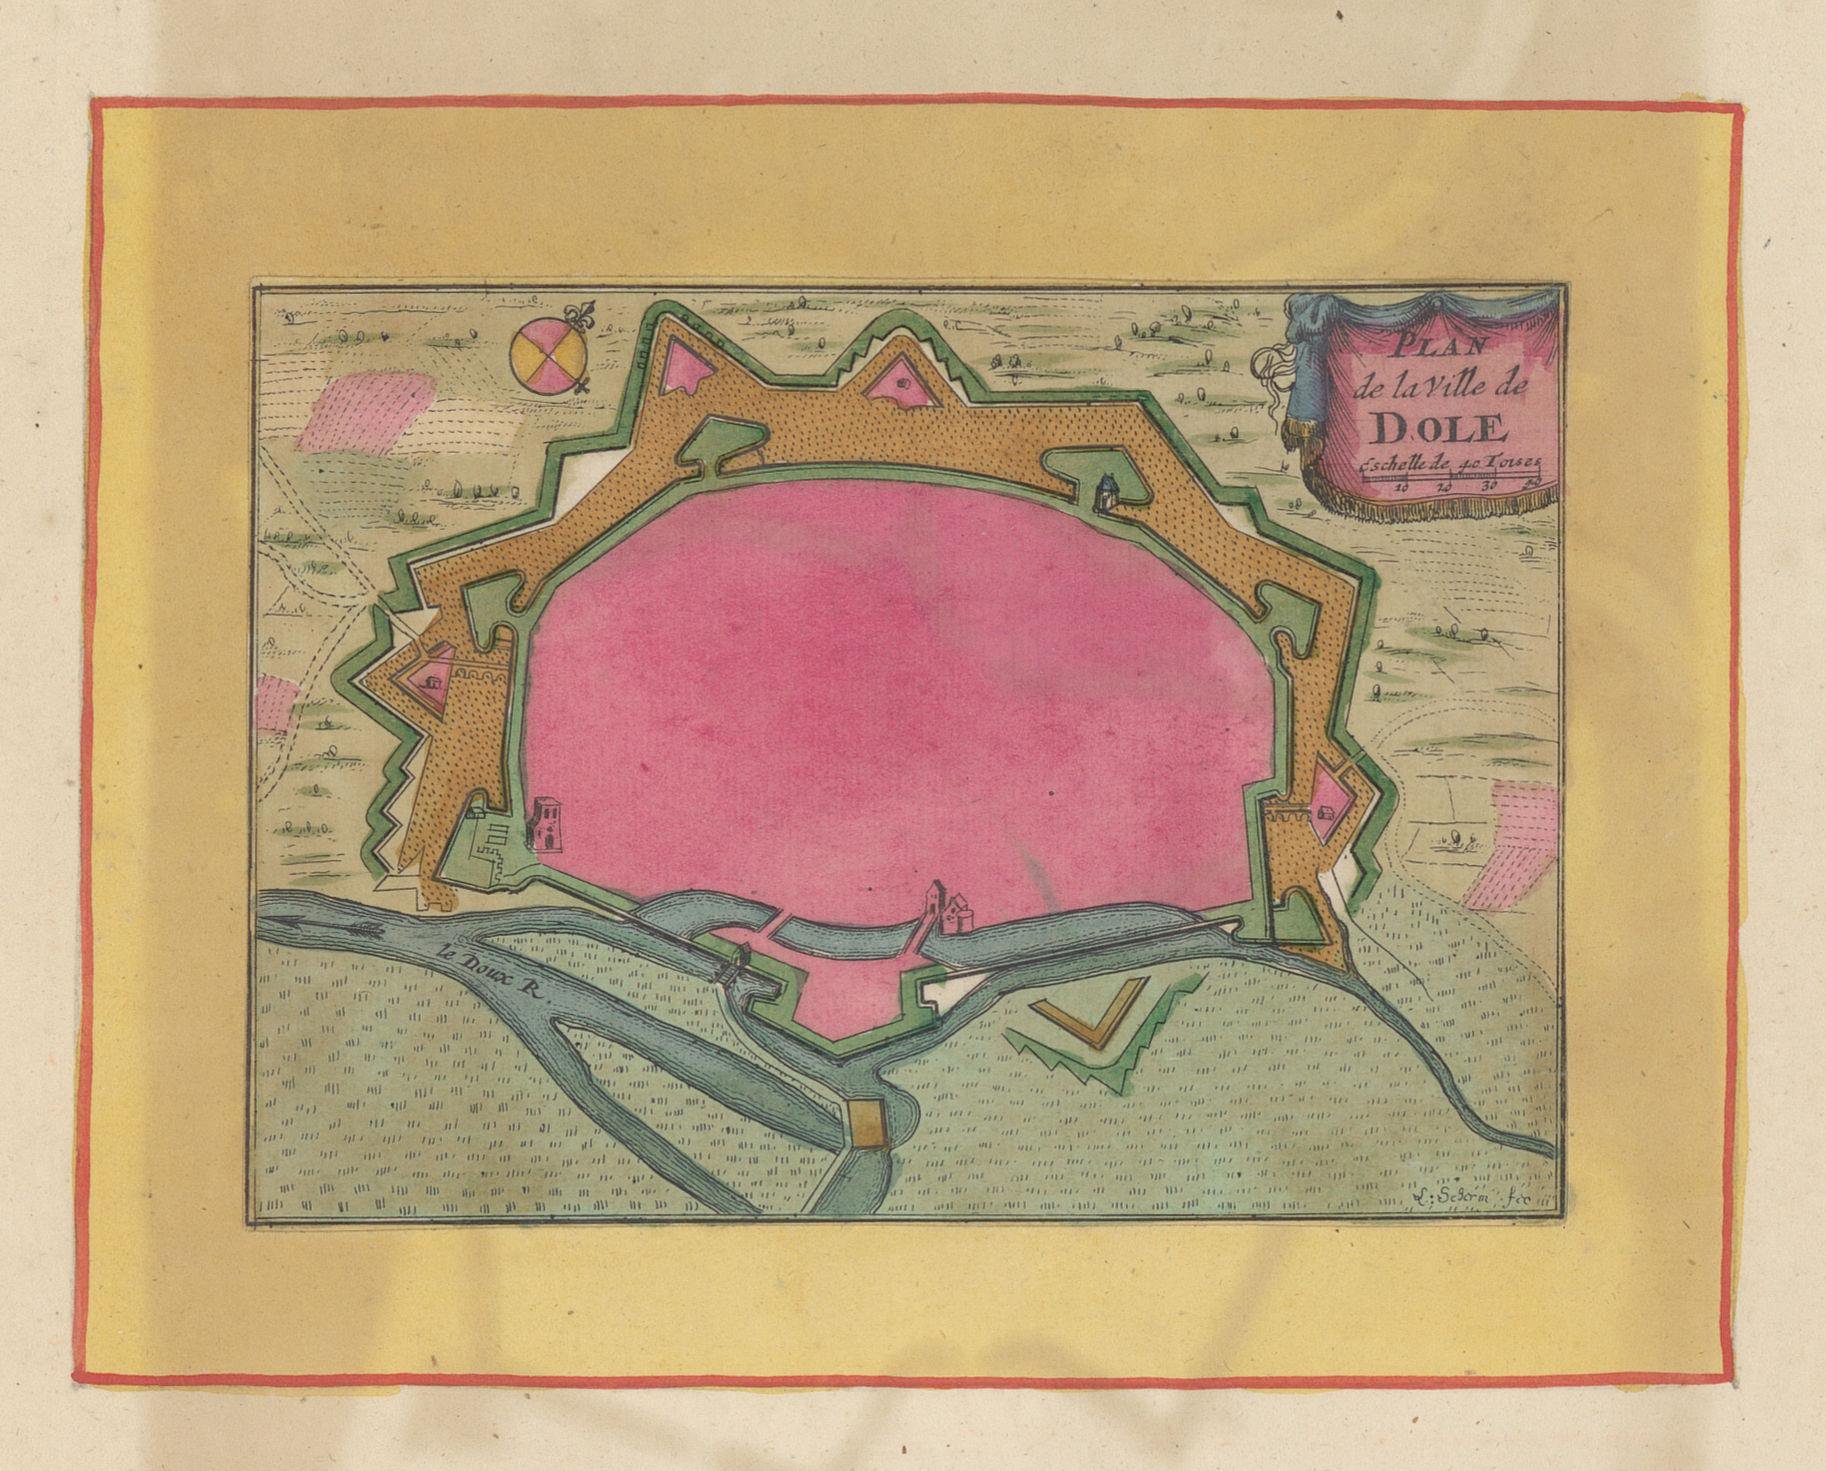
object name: area plan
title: Vestingplattegrond van Dôle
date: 1700-1702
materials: paper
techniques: engraving, hand coloring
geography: the hague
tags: maps of cities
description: Deze plattegrond is in meerdere atlassen gebruikt. Onder andere in: Les forces de l'Europe. 10 dln. Amsterdam: Pieter Mortier, ca. 1700. En in: Les forces de l'Europe. 12 dln. Amsterdam: Pieter Mortier, 1702. Door het ontbreken van de marges van deze prent is onduidelijk om welke staat het gaat. Derhalve is niet te bepalen uit welke van deze publicaties dit exemplaar komt. Later is deze zelfde prent door Pieter van der Aa gebruikt in twee publicaties. Gezien het eind van de werkzame periode van de inkleurder van de prenten in dit album is het niet mogelijk dat deze prent uit een van die publicaties komt.